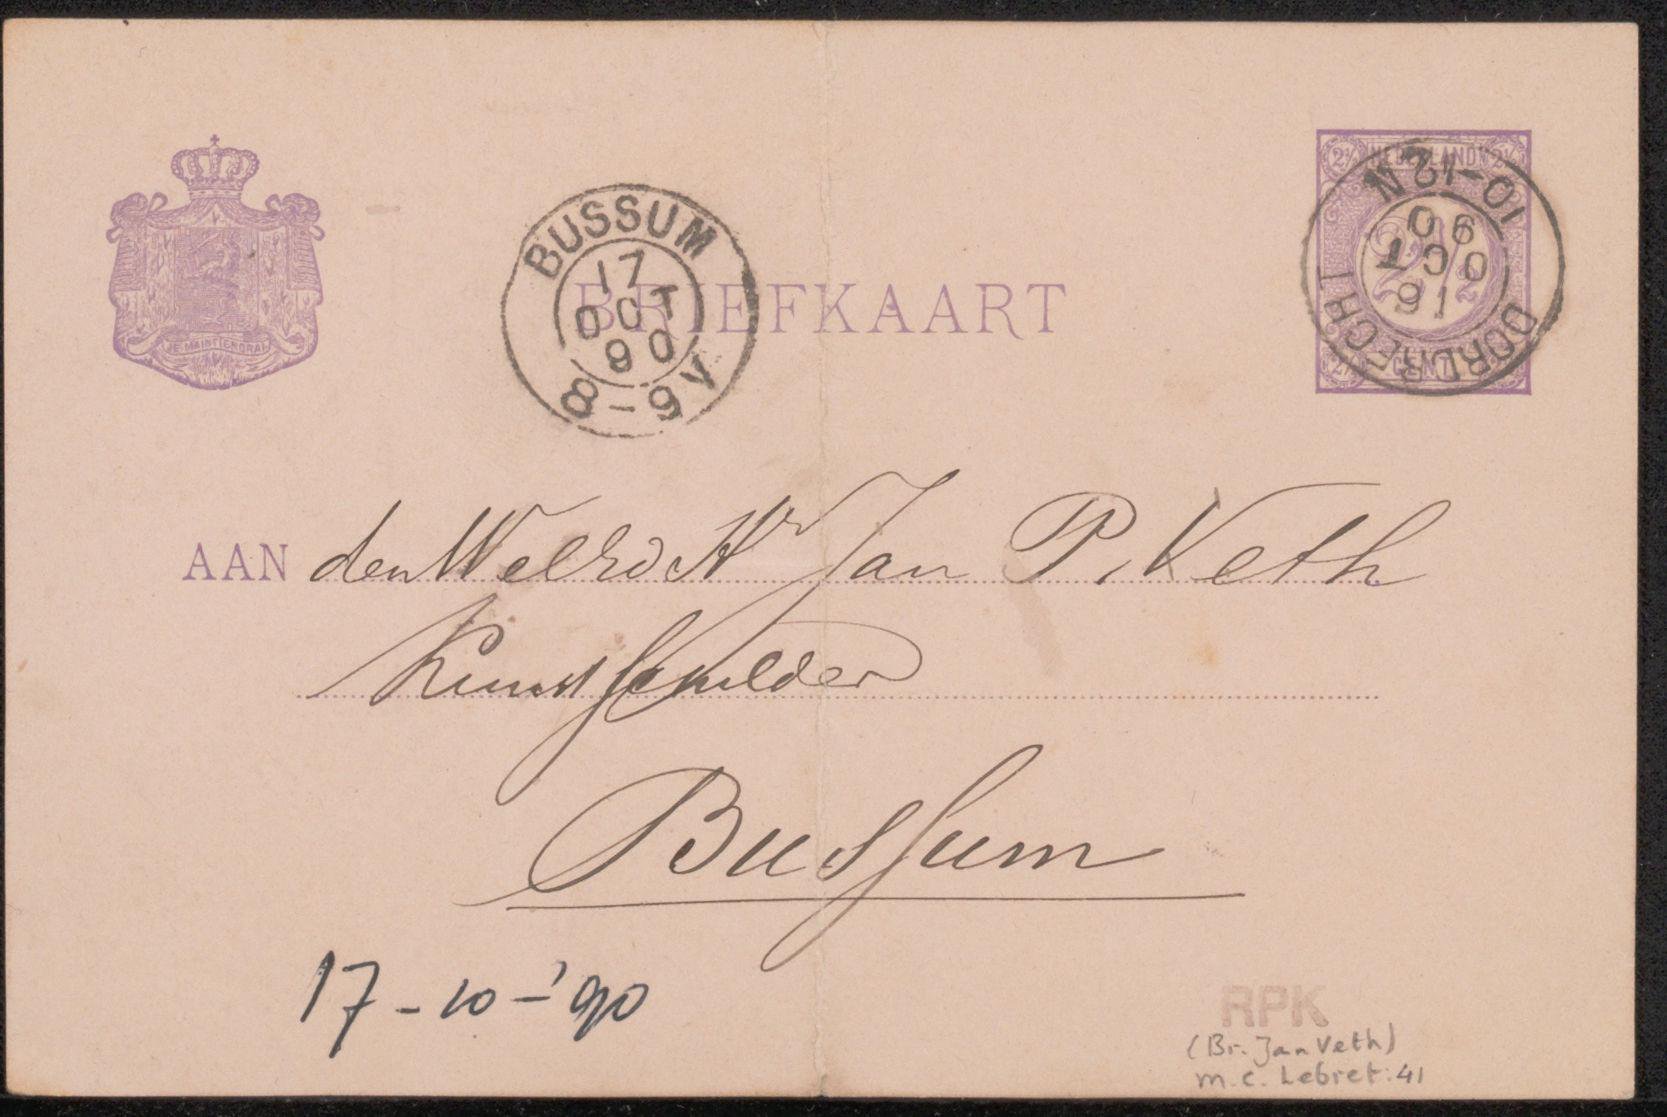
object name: letter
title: Briefkaart aan Jan Veth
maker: martinus cornelis lebret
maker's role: verzamelaar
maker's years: 1833-1894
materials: cardboard, ink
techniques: pen, writing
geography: dordrecht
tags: jozef israëls, haarlem, théophile de bock, george hendrik breitner, dordrecht, painter, print maker, draughtsman, designer, jan veth, the hague, willem maris, arnhem, anton mauve, utrecht, albert neuhuys (1844-1914), nicolaas bastert, exhibition ~ art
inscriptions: collector's mark: ‘RPK’